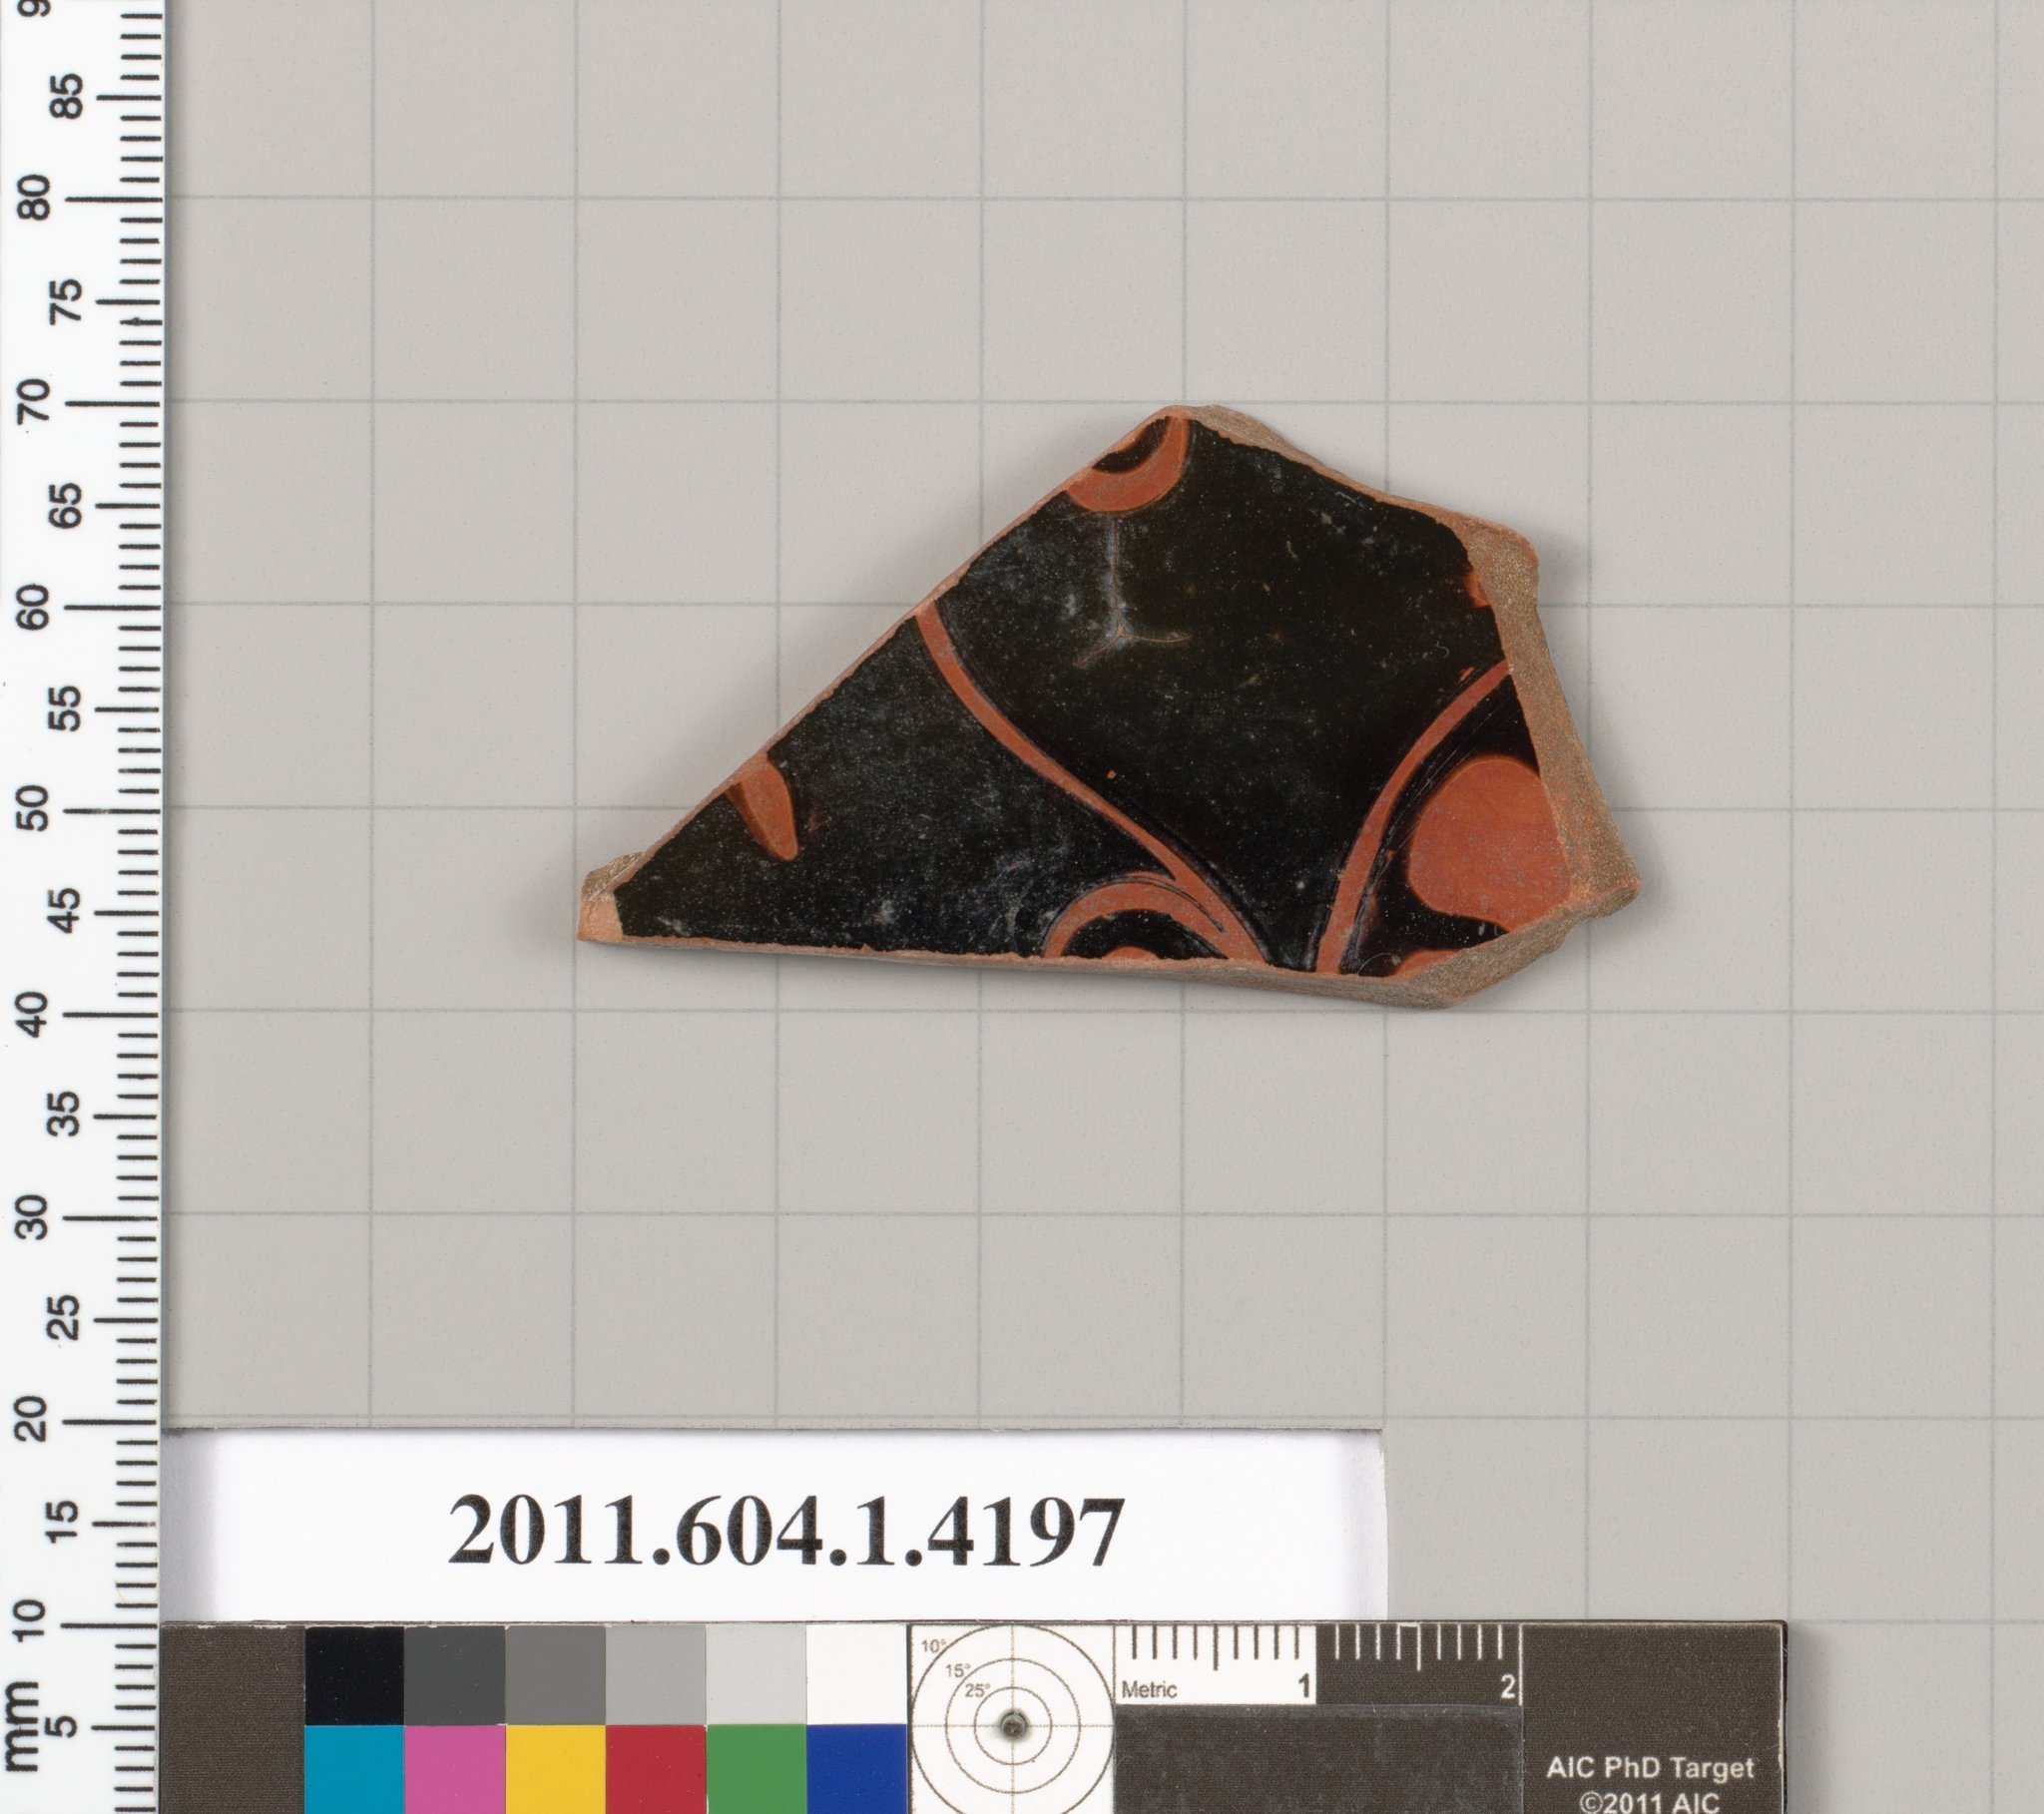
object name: kylix fragment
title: Terracotta fragment of a kylix (drinking cup)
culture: greek, attic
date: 500-480 BCE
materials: terracotta